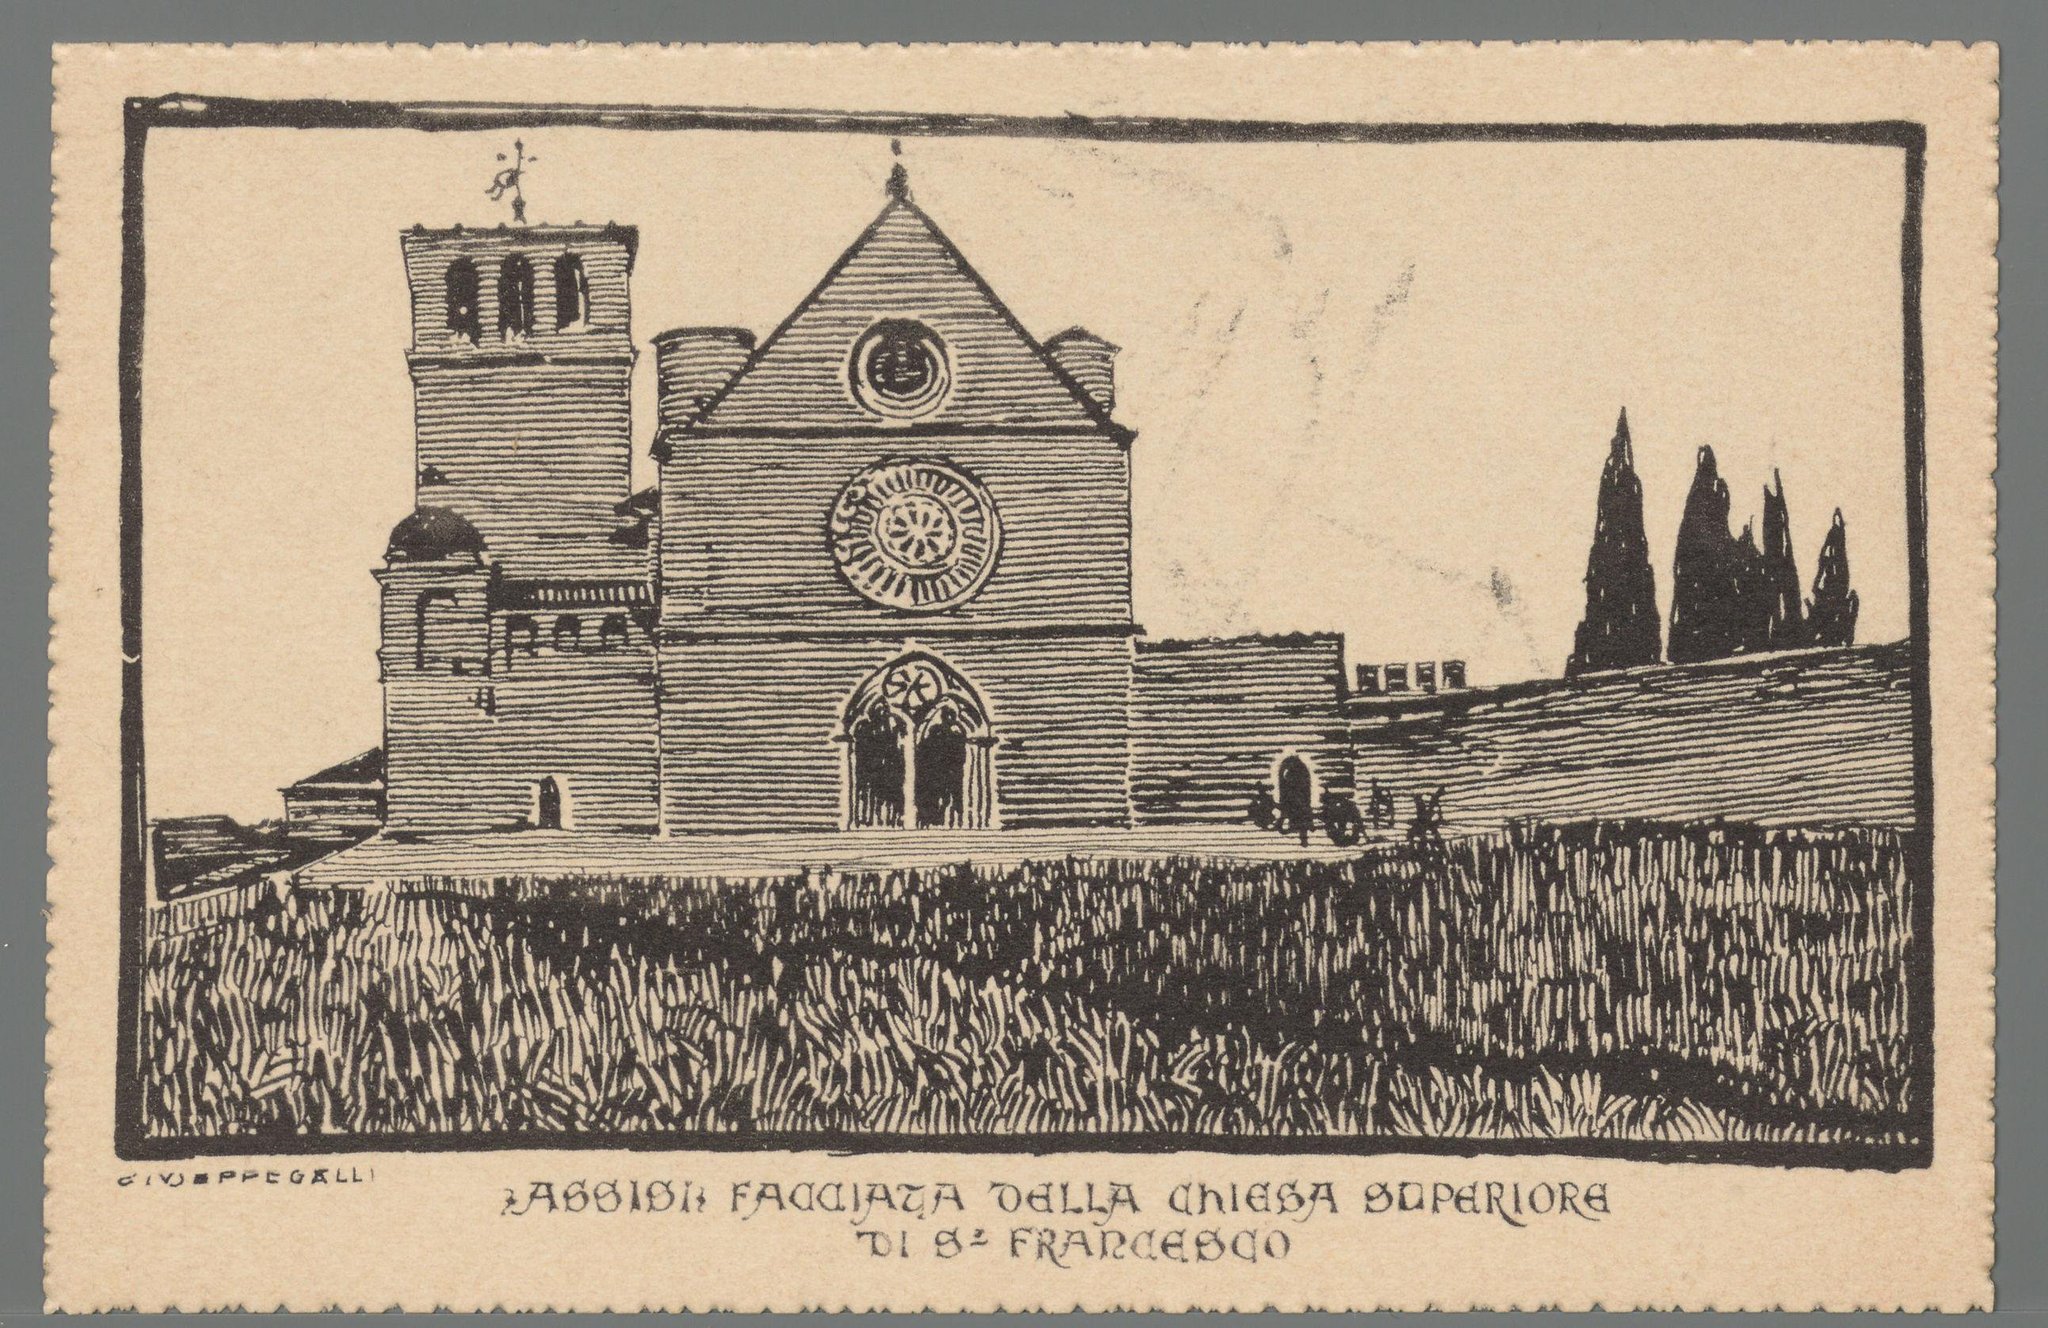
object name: ansichtkaart, prentbriefkaart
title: Assisi. Facciata della Chiesa Superiore di S. Francesco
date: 1923-1930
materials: cardboard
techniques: photograph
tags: church (exterior)